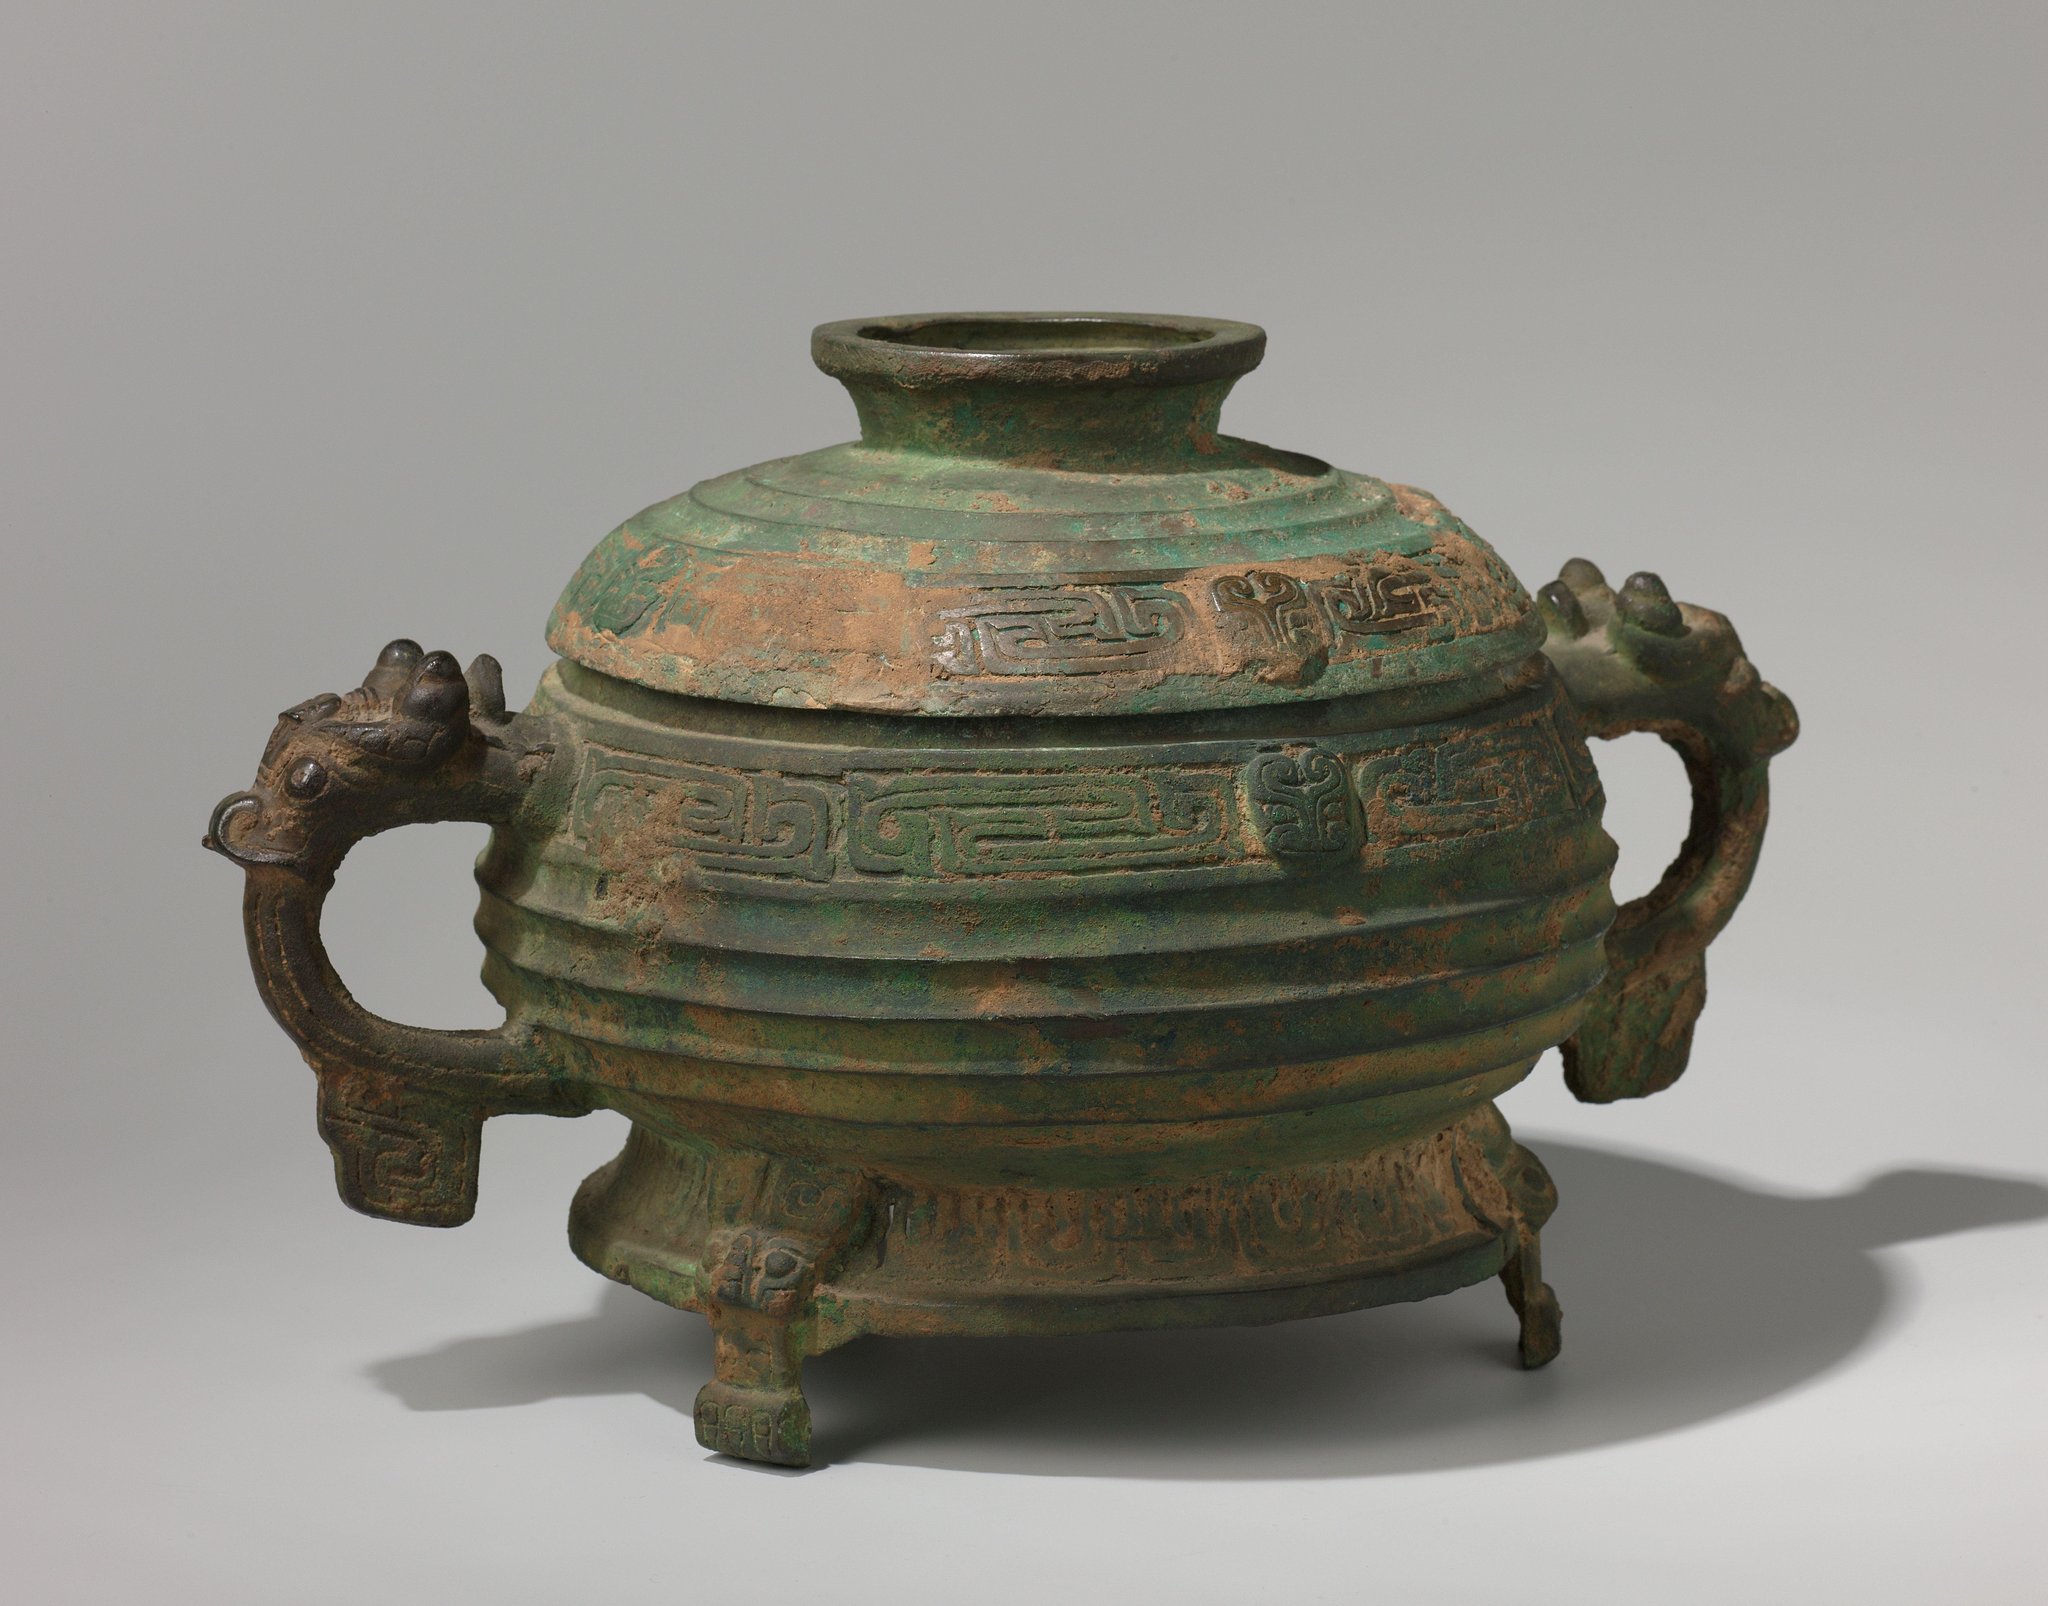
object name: religious ritual object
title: Rituele offerschaal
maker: Anonymous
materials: bronze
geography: china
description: Ritueel vat voor voedsel met decoratie op twee banden en cirkels in reliëf over de buik. De oren hebben de vorm van een monster dat een gestileerde vogel verslindt.